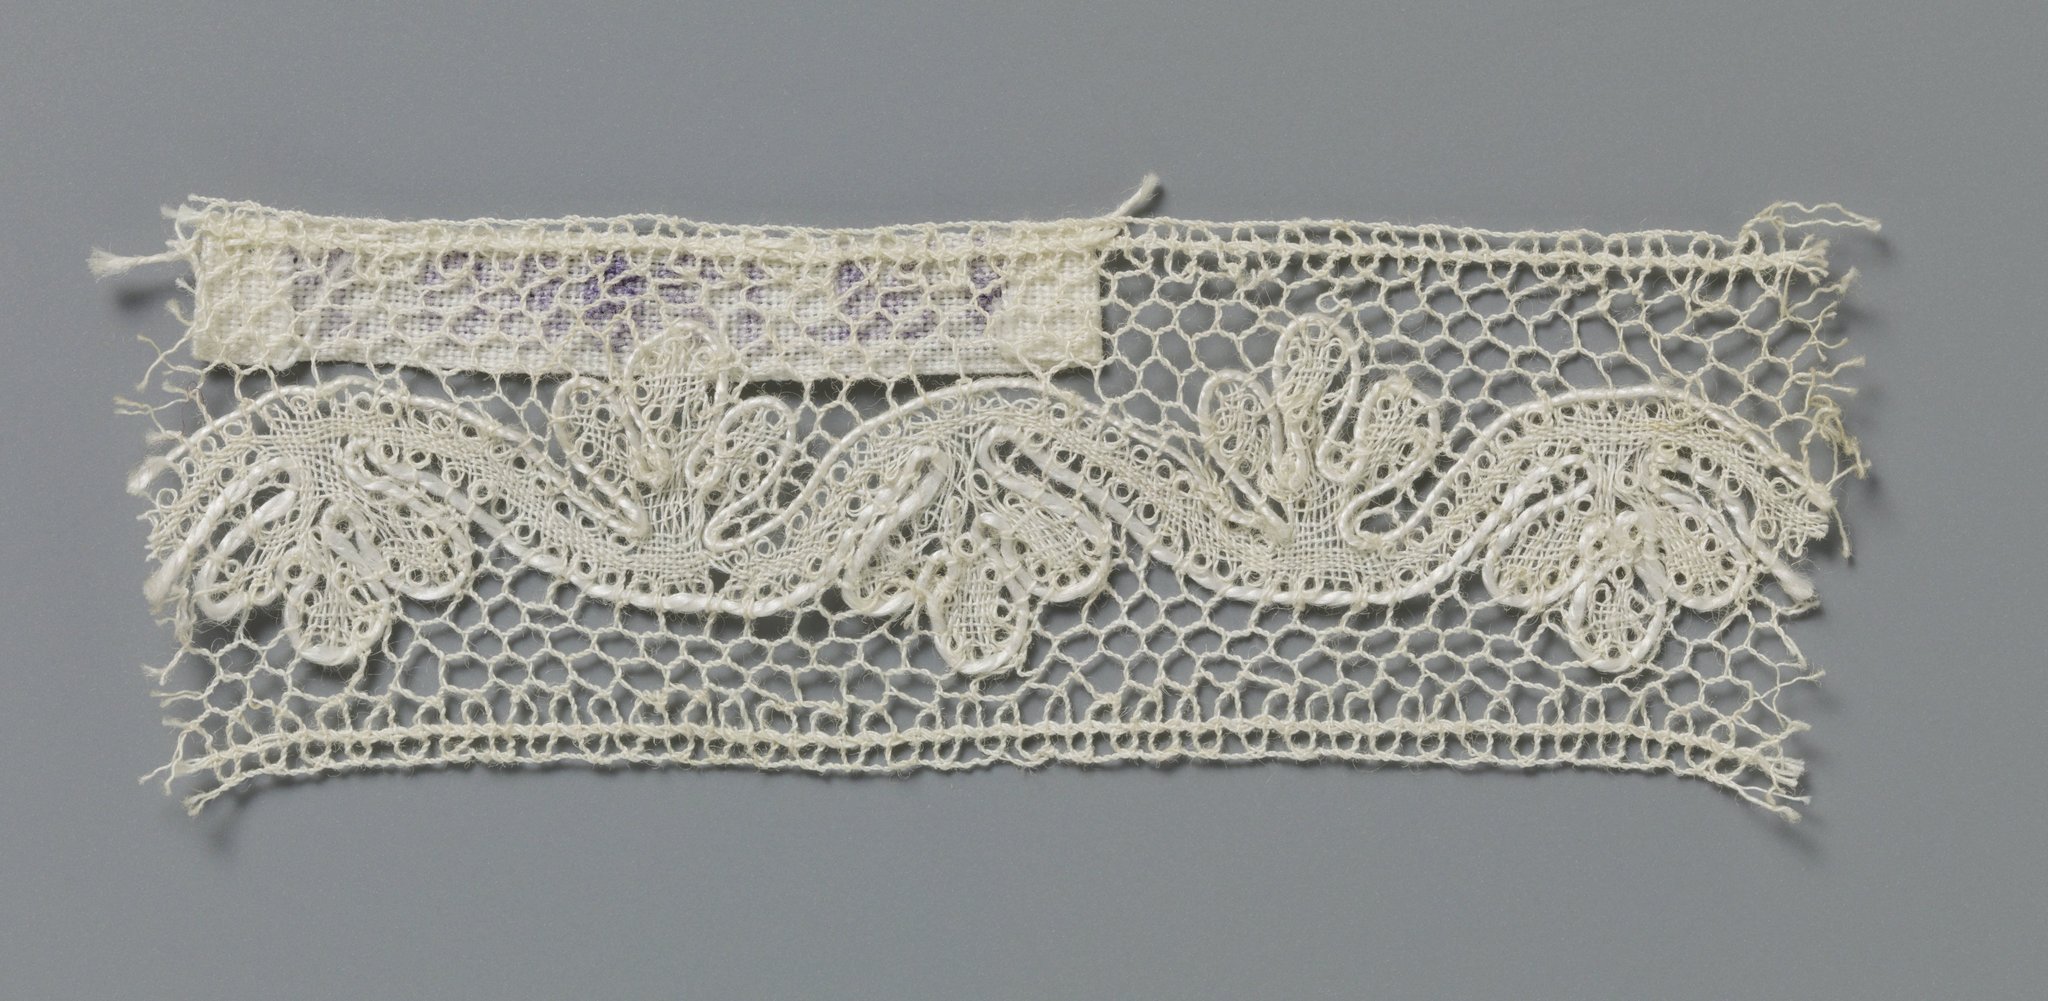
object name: strip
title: Strook kloskant met een golvende lijn en drielobbige bladeren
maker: Anonymous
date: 1800-1899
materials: cotton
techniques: lace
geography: buckingham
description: Strook naturelkleurige kloskant, Buckingham-kant. Het zich herhalende en doorlopende patroon bestaat op de middenlijn uit een regelmatig golvende lijn. Vanuit elk golfdal en elke golftop ontspringt een drielobbig blad dat iets boven of onder de golven uitsteekt. De golven en bladeren zijn gemaakt in linnenslag en zijn aan alle zijden voorzien van dikke en glimmende contourdraden. De strook bestaat verder uit een maasgrond, een tulegrond. Boven- en onderzijde van de strook zijn recht afgewerkt.